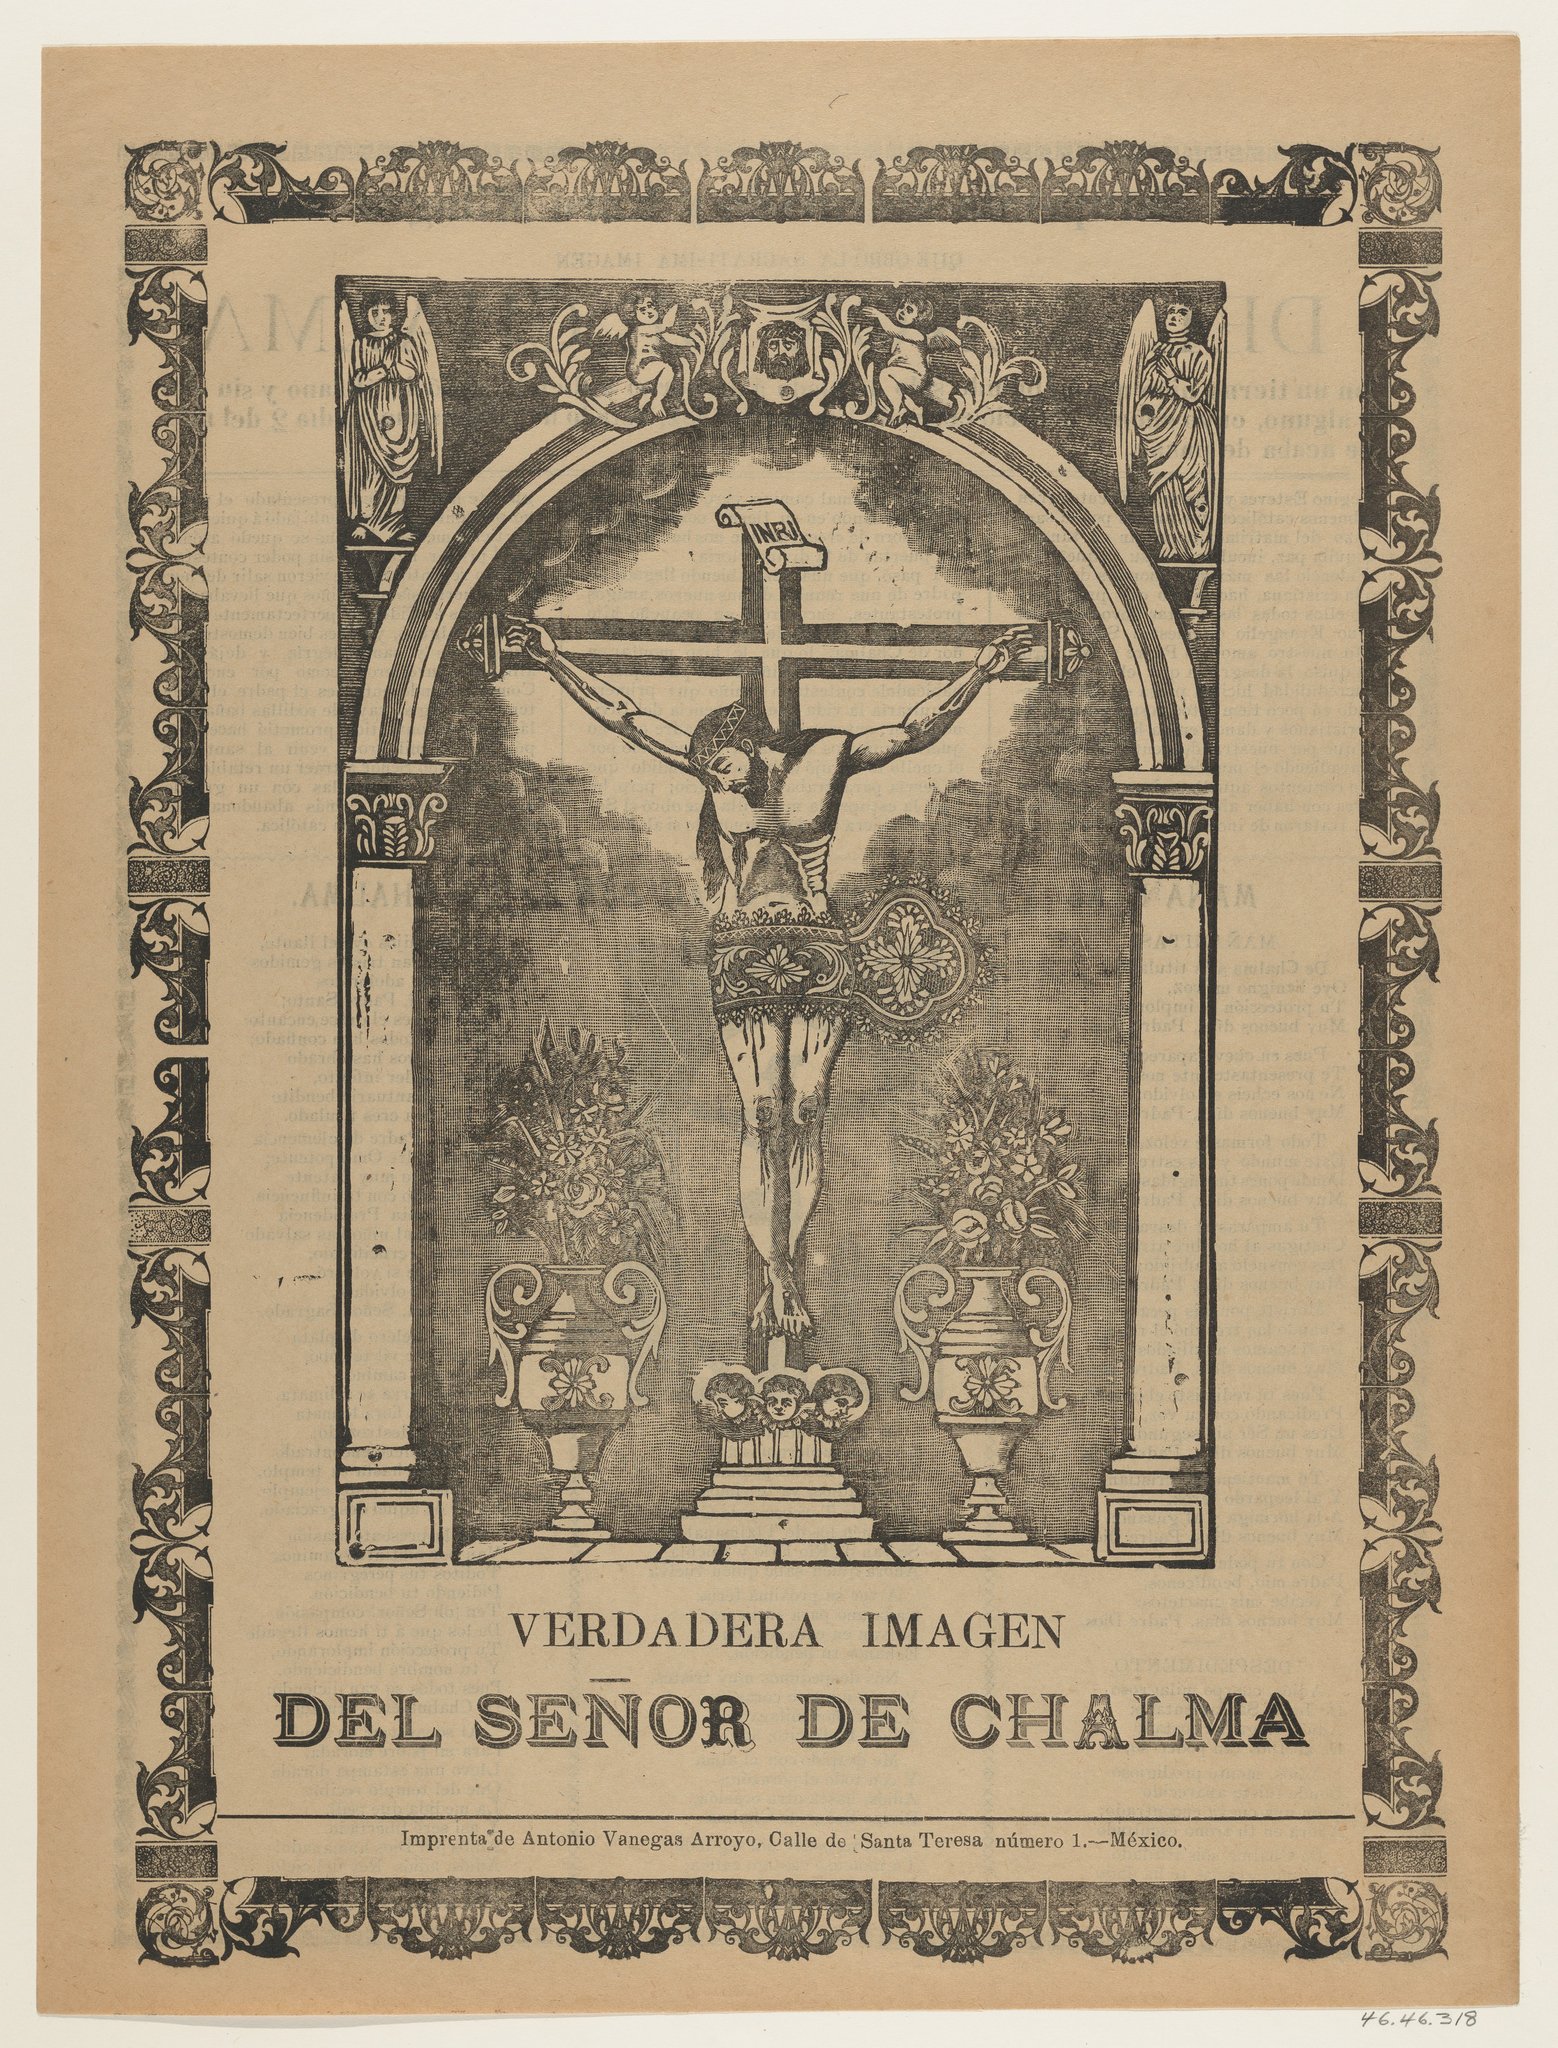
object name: print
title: True Image of the Lord of Chalma, Christ crucified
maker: josé guadalupe posada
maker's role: artist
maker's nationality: mexican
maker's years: 1852-1913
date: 1903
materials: metal, paper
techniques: engraving, letterpress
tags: angels,christ,cross,crucifixion